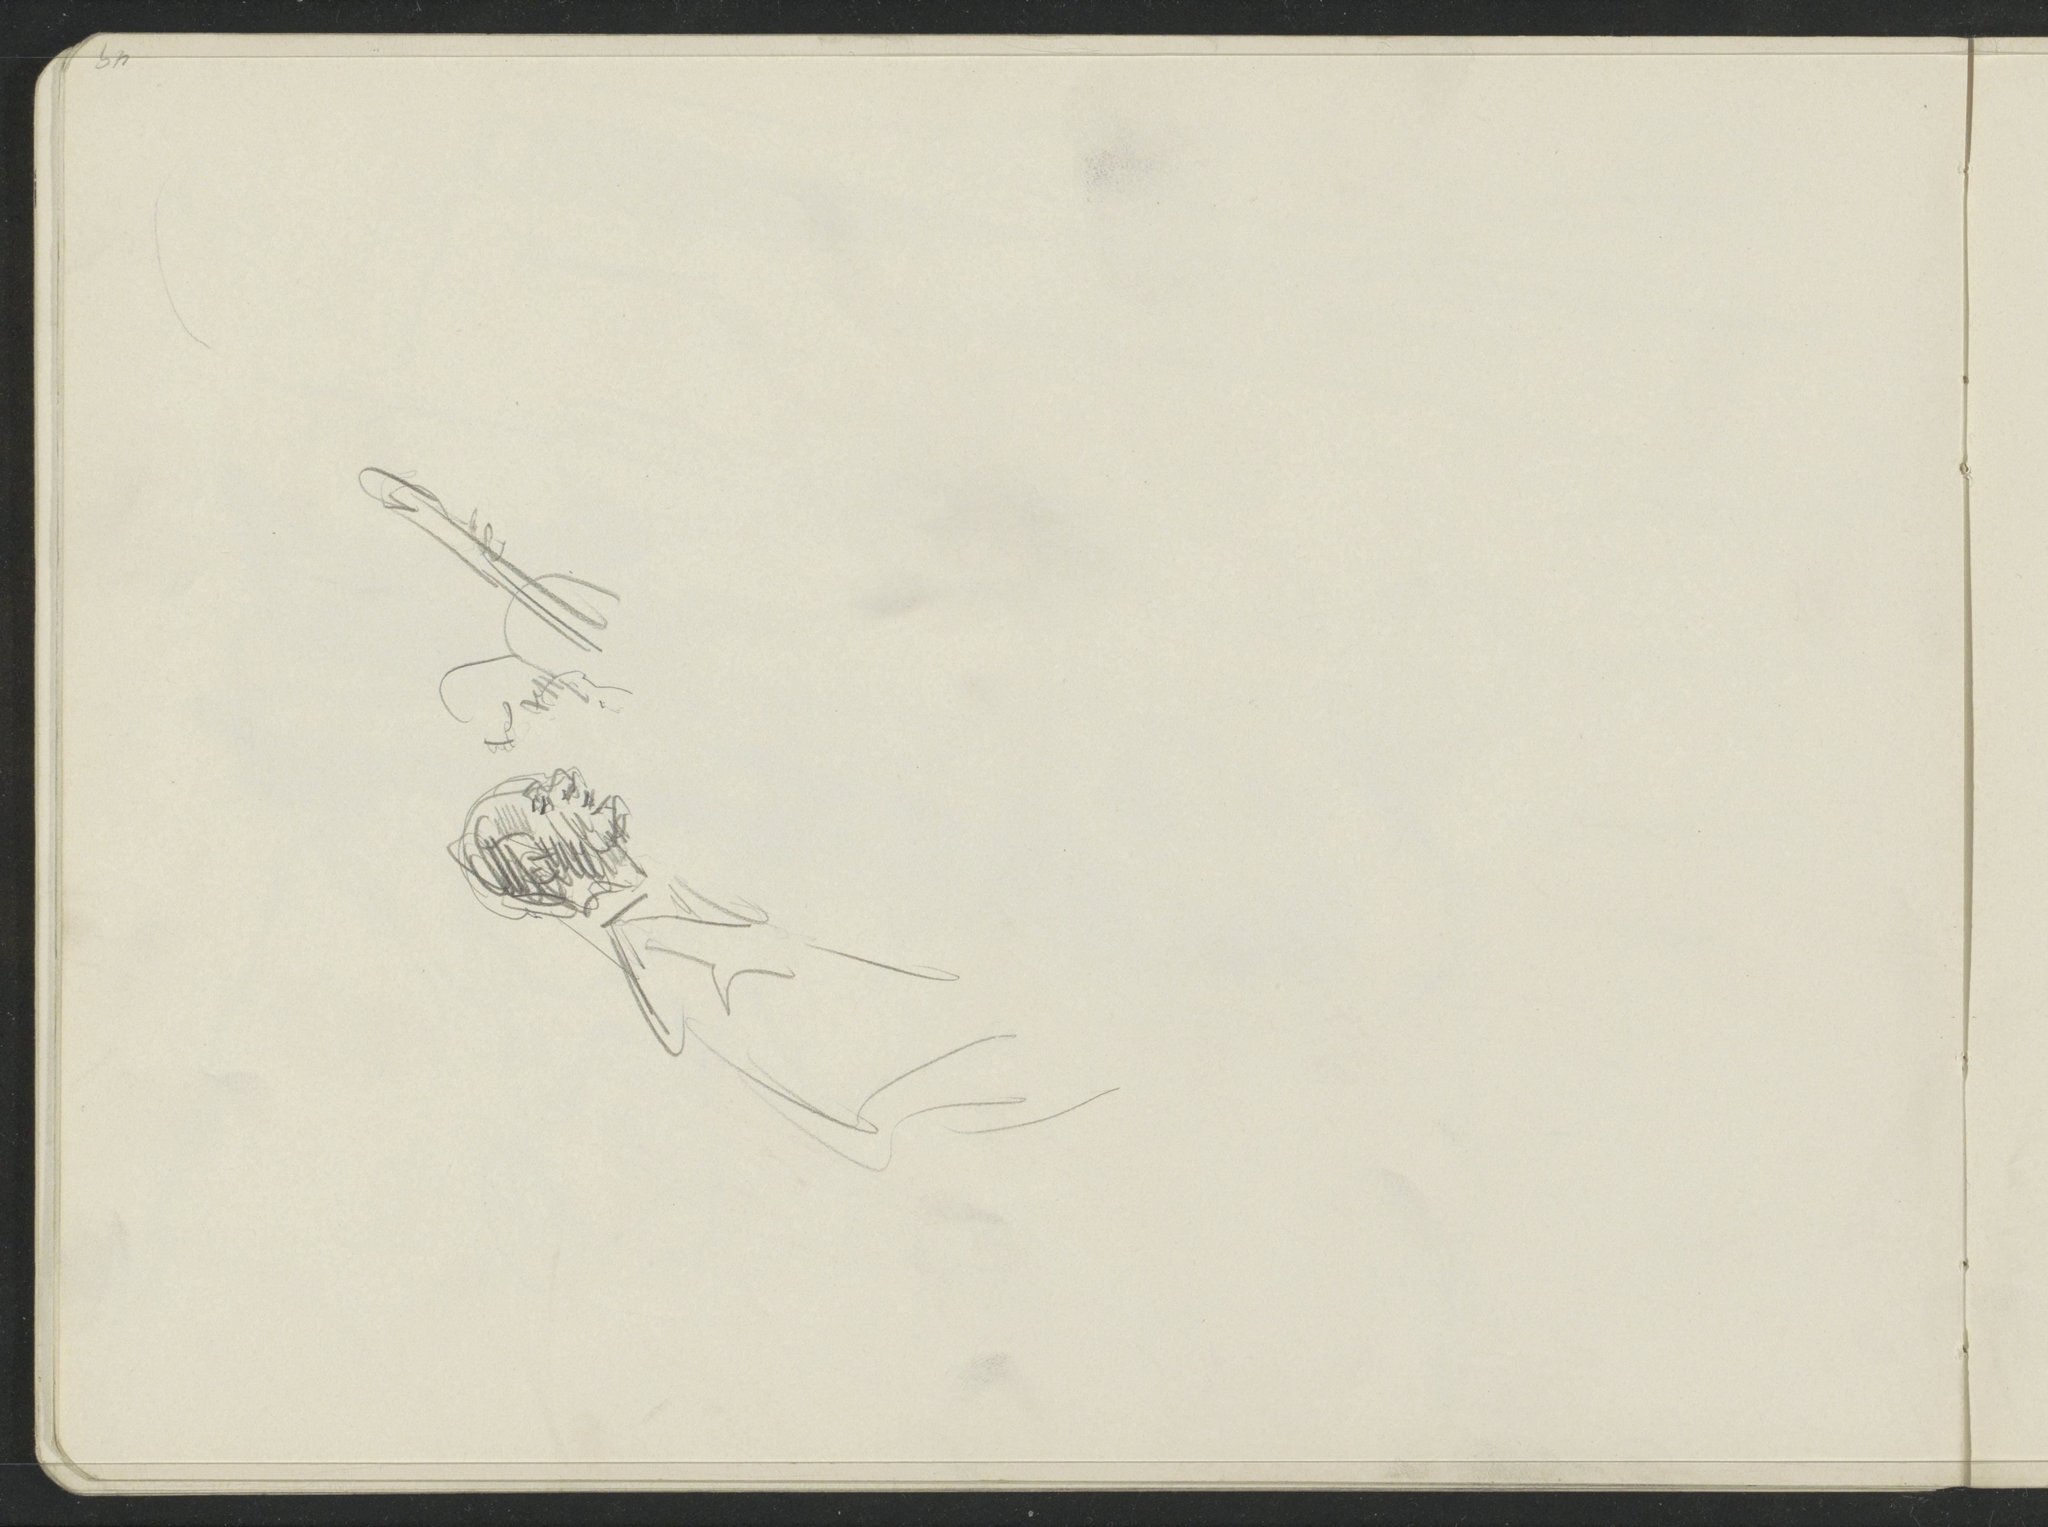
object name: sketchbook leaf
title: Staande man, in profiel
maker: isaac israels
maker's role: draughtsman, painter, print maker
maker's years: 1865-1934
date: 1915-1934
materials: paper, pencil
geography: the hague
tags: adult man (+ sideview, profile)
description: Blad 14 verso uit schetsboek XVII met 31 bladen.